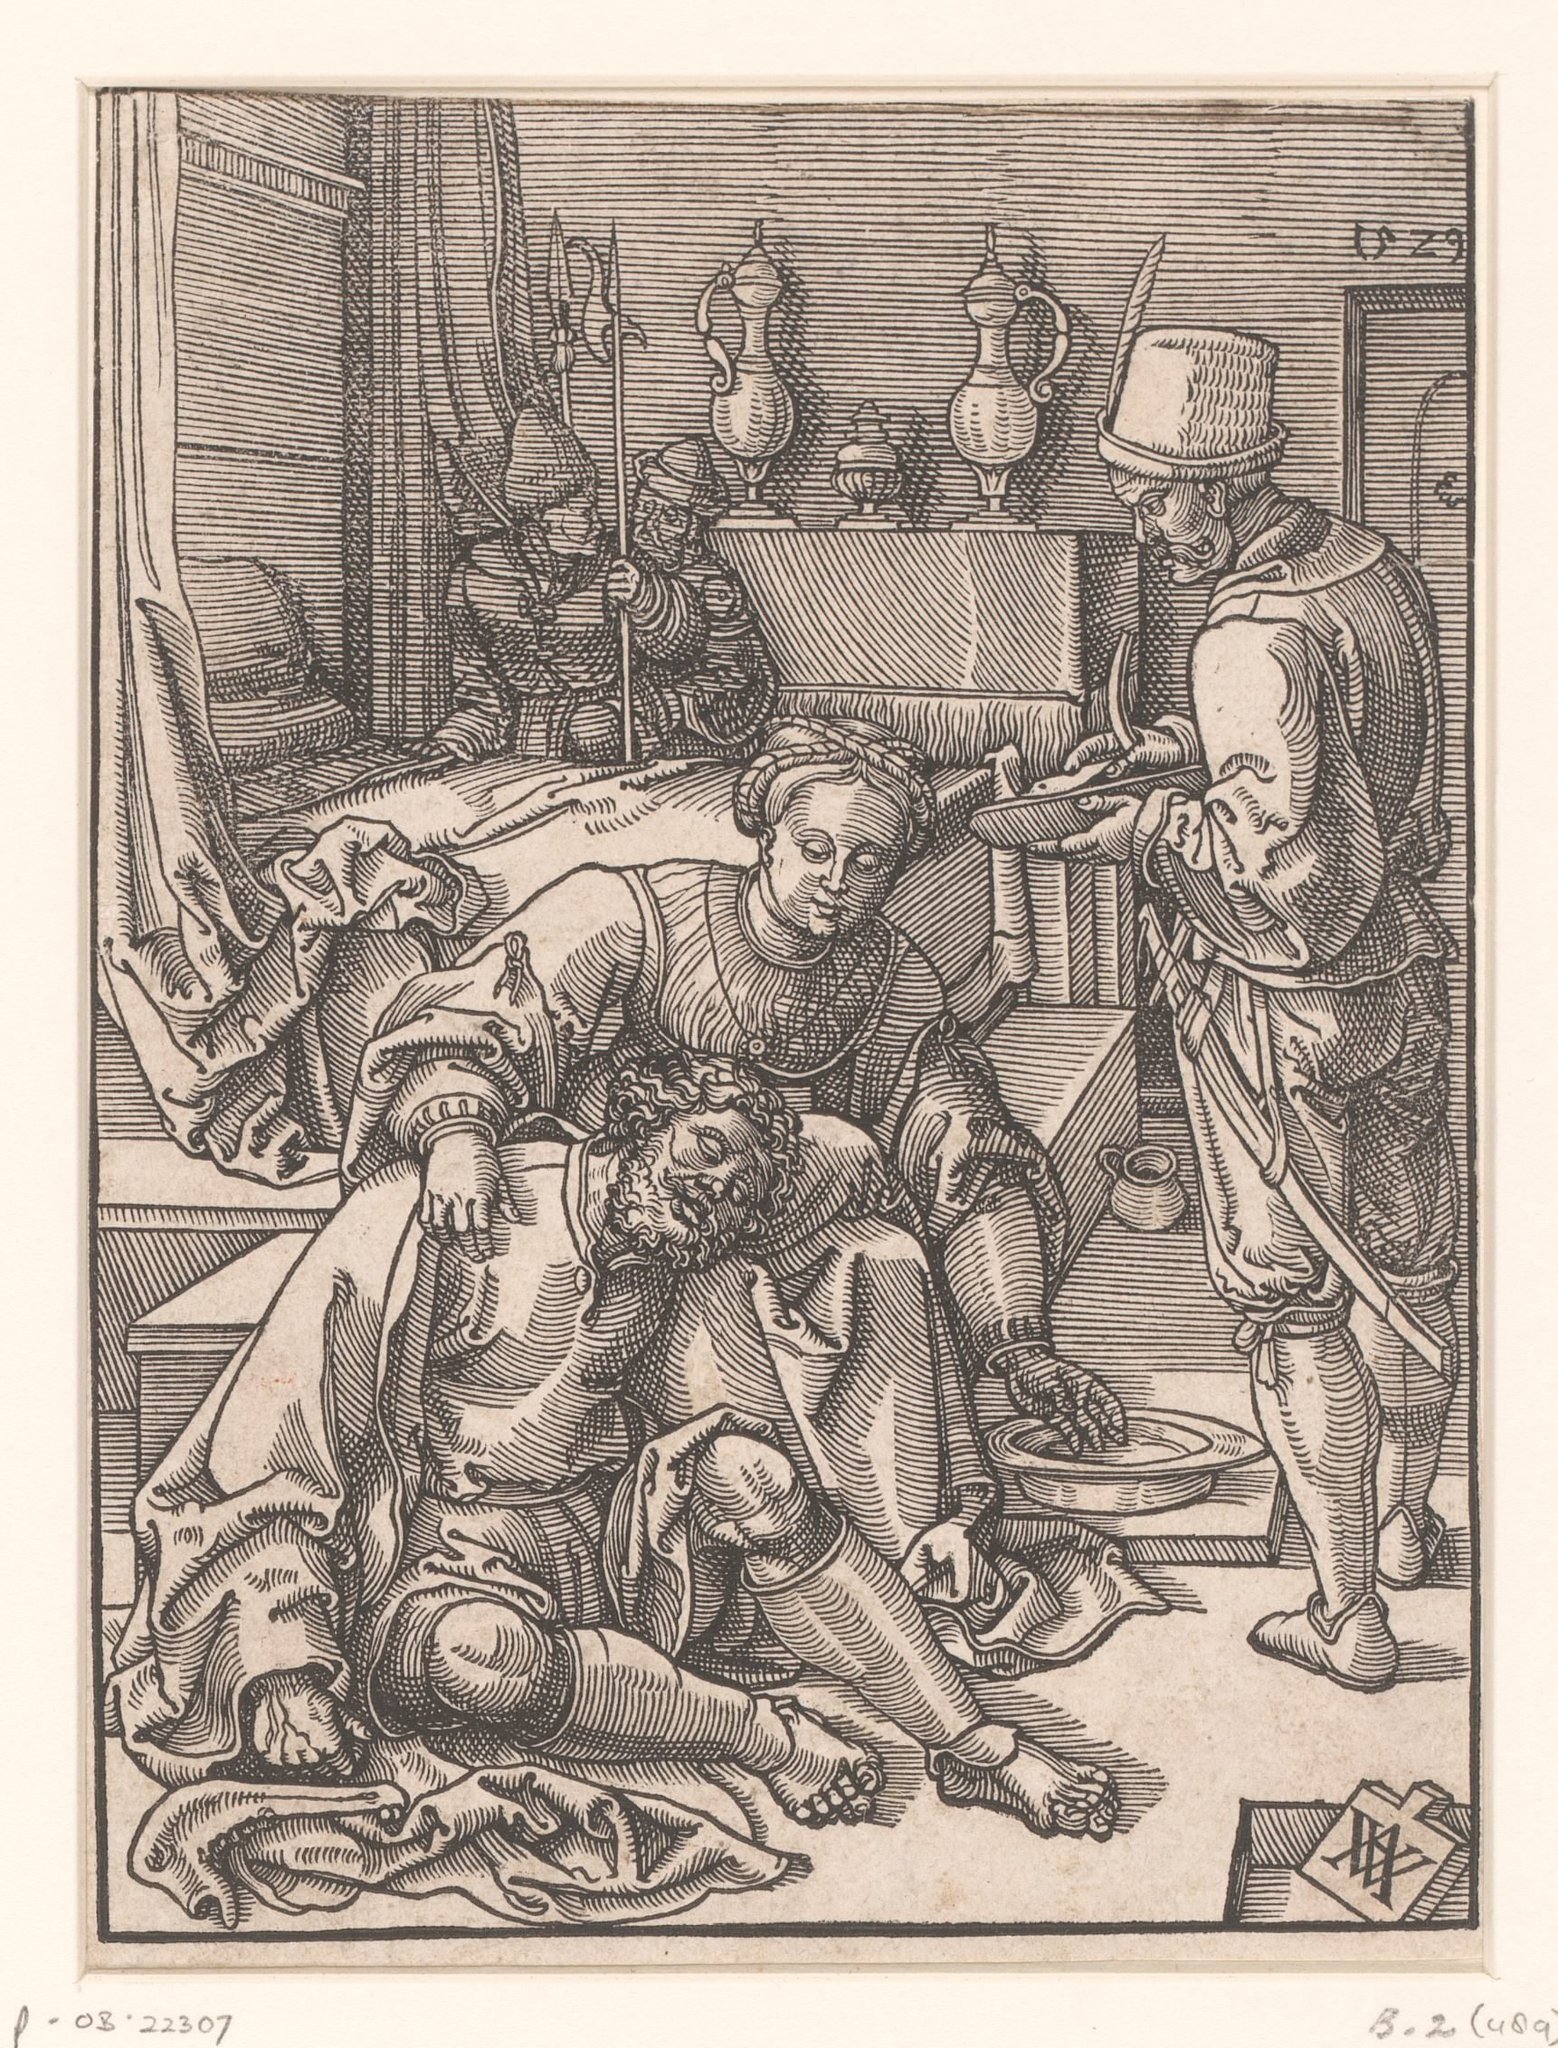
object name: print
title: Simson en Delila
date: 1529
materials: paper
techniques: woodcut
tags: story of samson and delilah (judges 16:4-21)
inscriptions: collector's mark: Lugt 240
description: Tweede prent in een reeks van mogelijk tien.